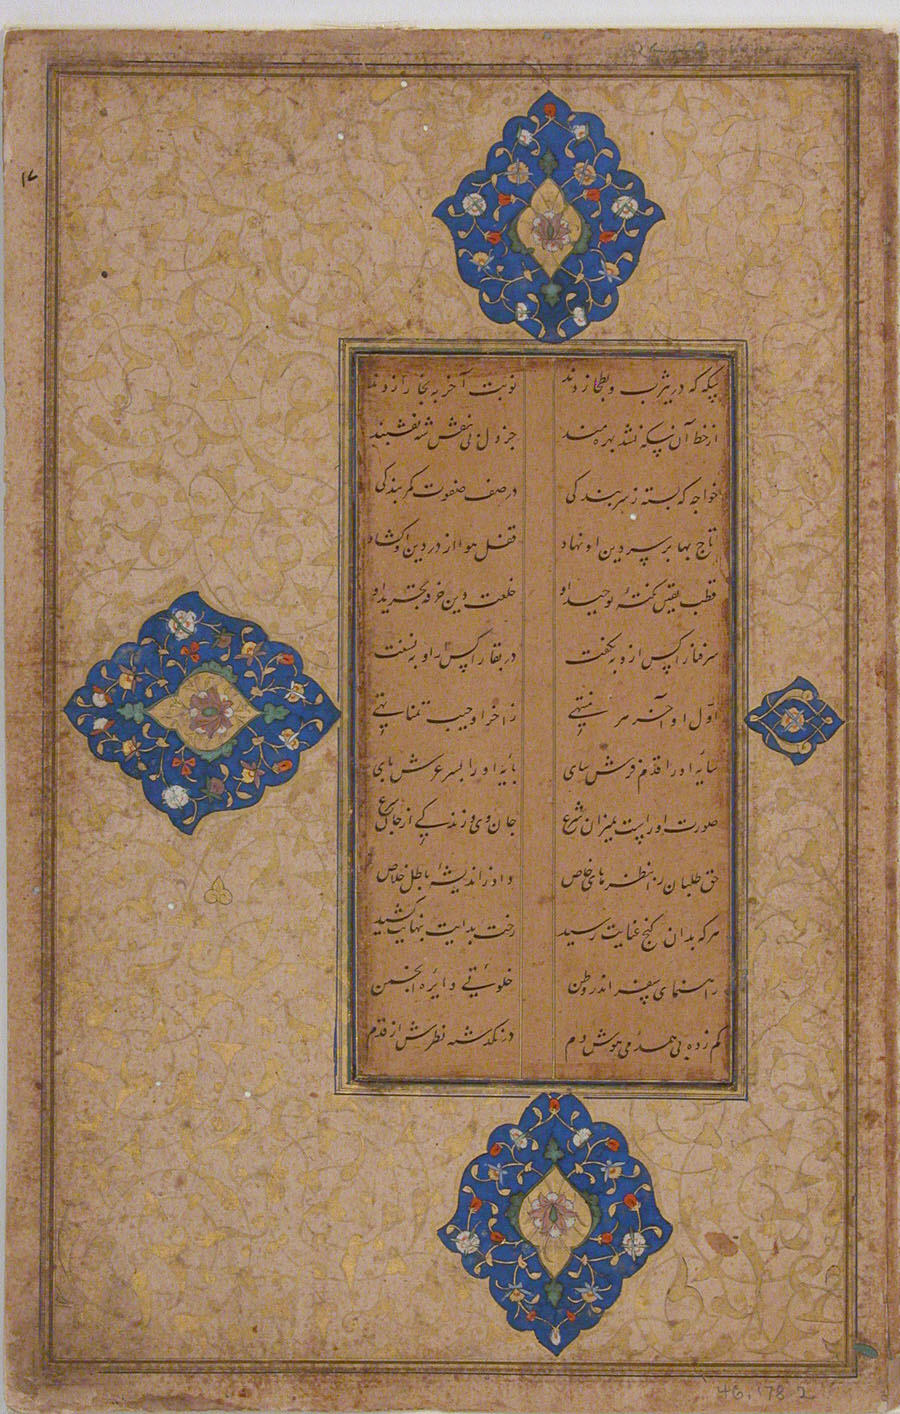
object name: folio from a non illustrated manuscript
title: Tuhfat al-Ahrar (The Gift to the Noble)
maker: maulana nur al-din `abd al-rahman jami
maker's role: author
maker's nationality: iranian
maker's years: 1414-1492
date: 1485-1490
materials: gold, ink, paper, watercolor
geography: afghanistan